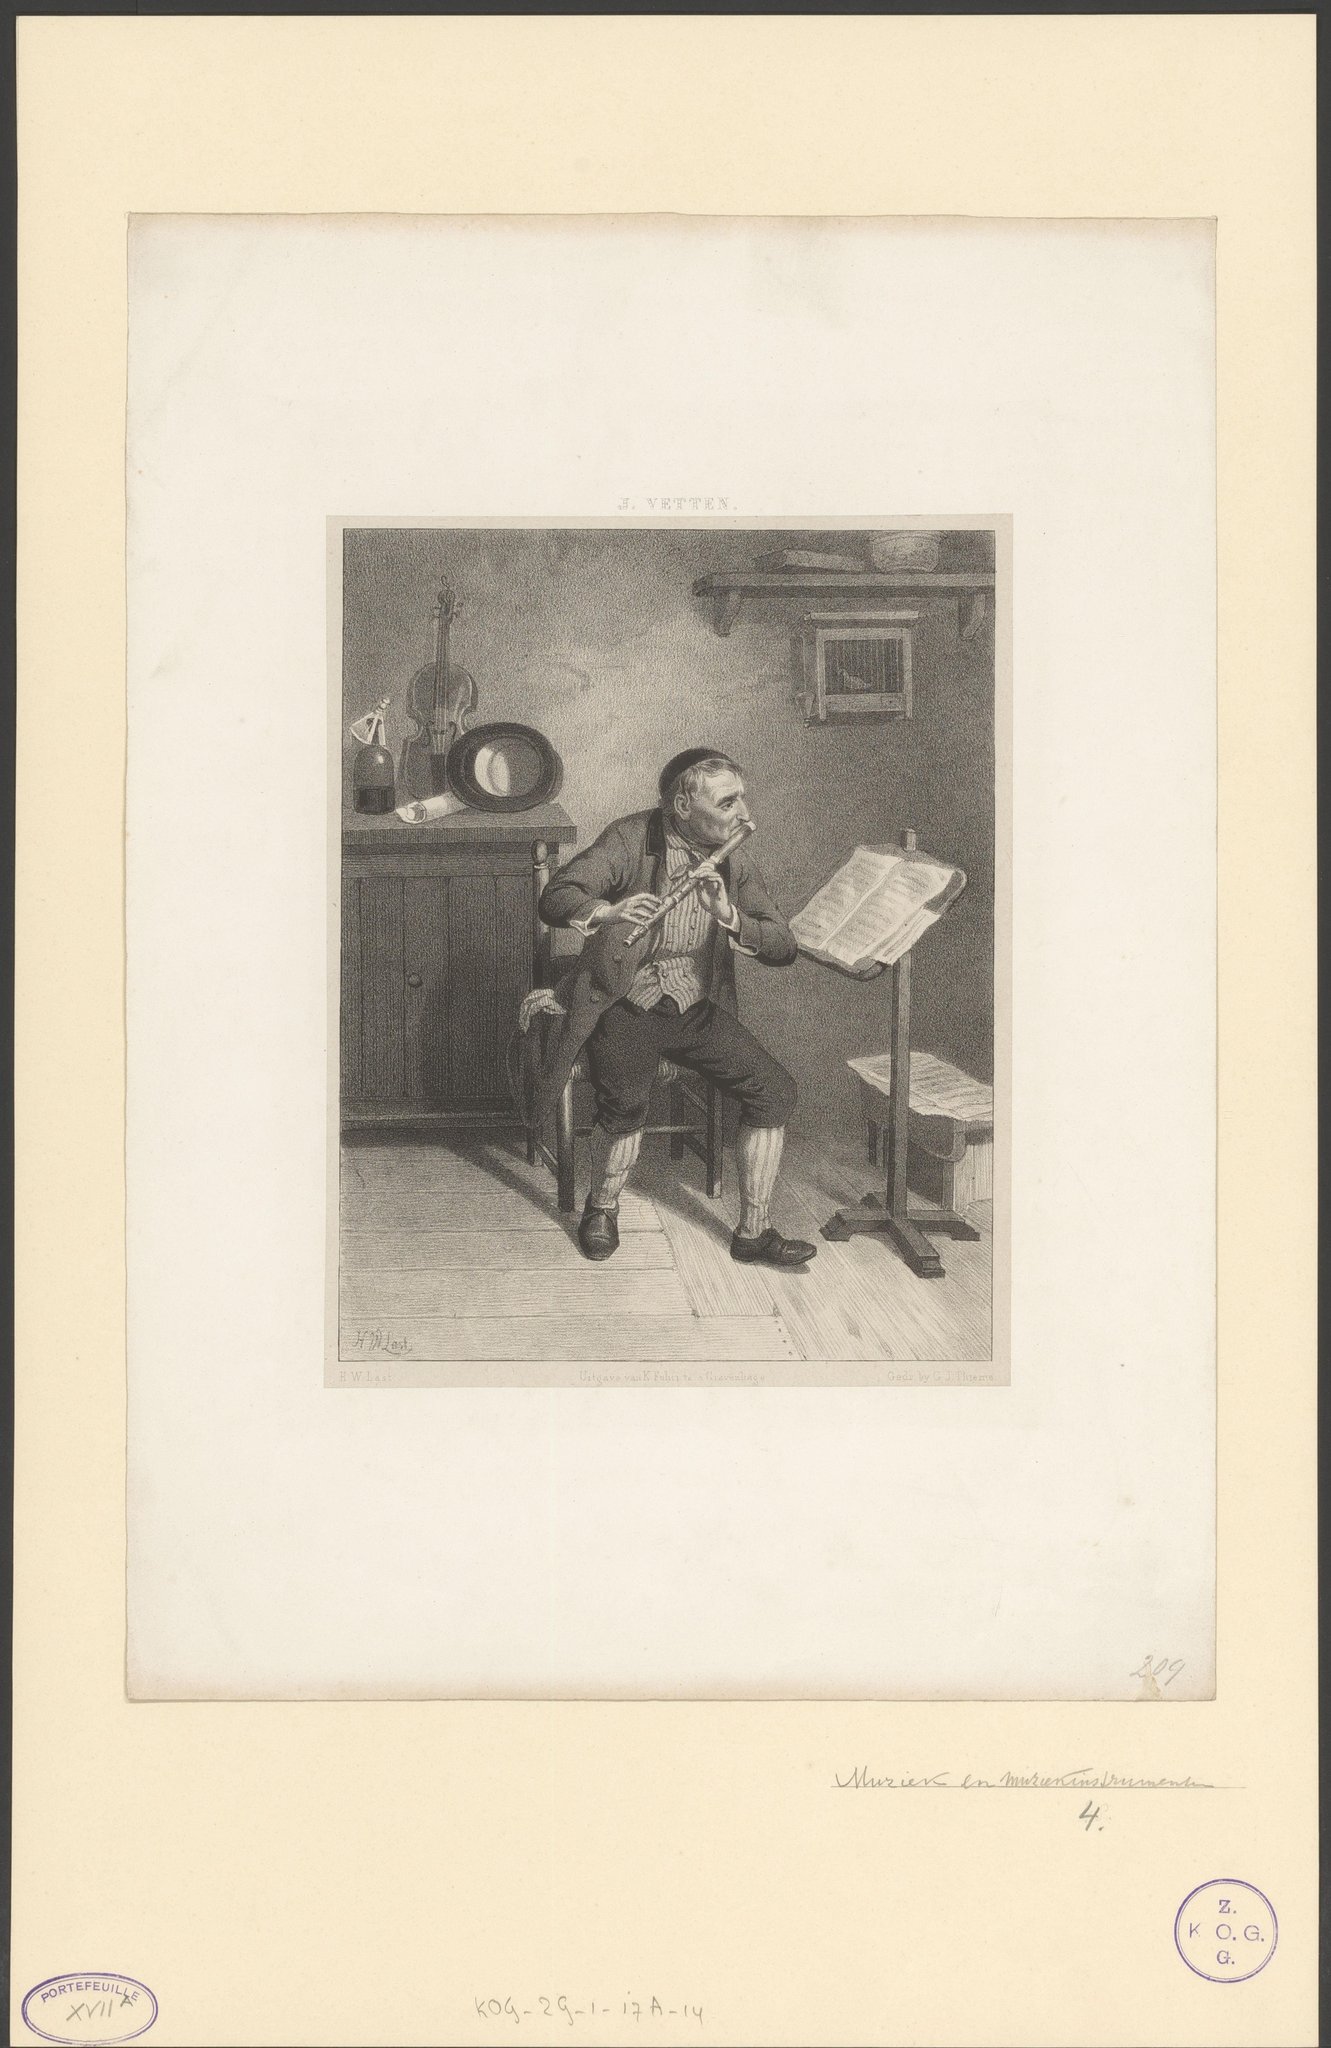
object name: print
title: De fluitspeler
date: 1837-1856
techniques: printmaking, lithograph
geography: the hague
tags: one person playing wind instrument, transverse flute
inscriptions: collector's mark: Lugt 1641, stamp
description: Een man spelend op een dwarsfluit. In een ruimte met bladmuziek op een standaard. Onderwerpsrubrieken binnen de Atlas Zeden en Gewoonten: Muziek en muziekinstrumenten: Blaasinstrumenten.